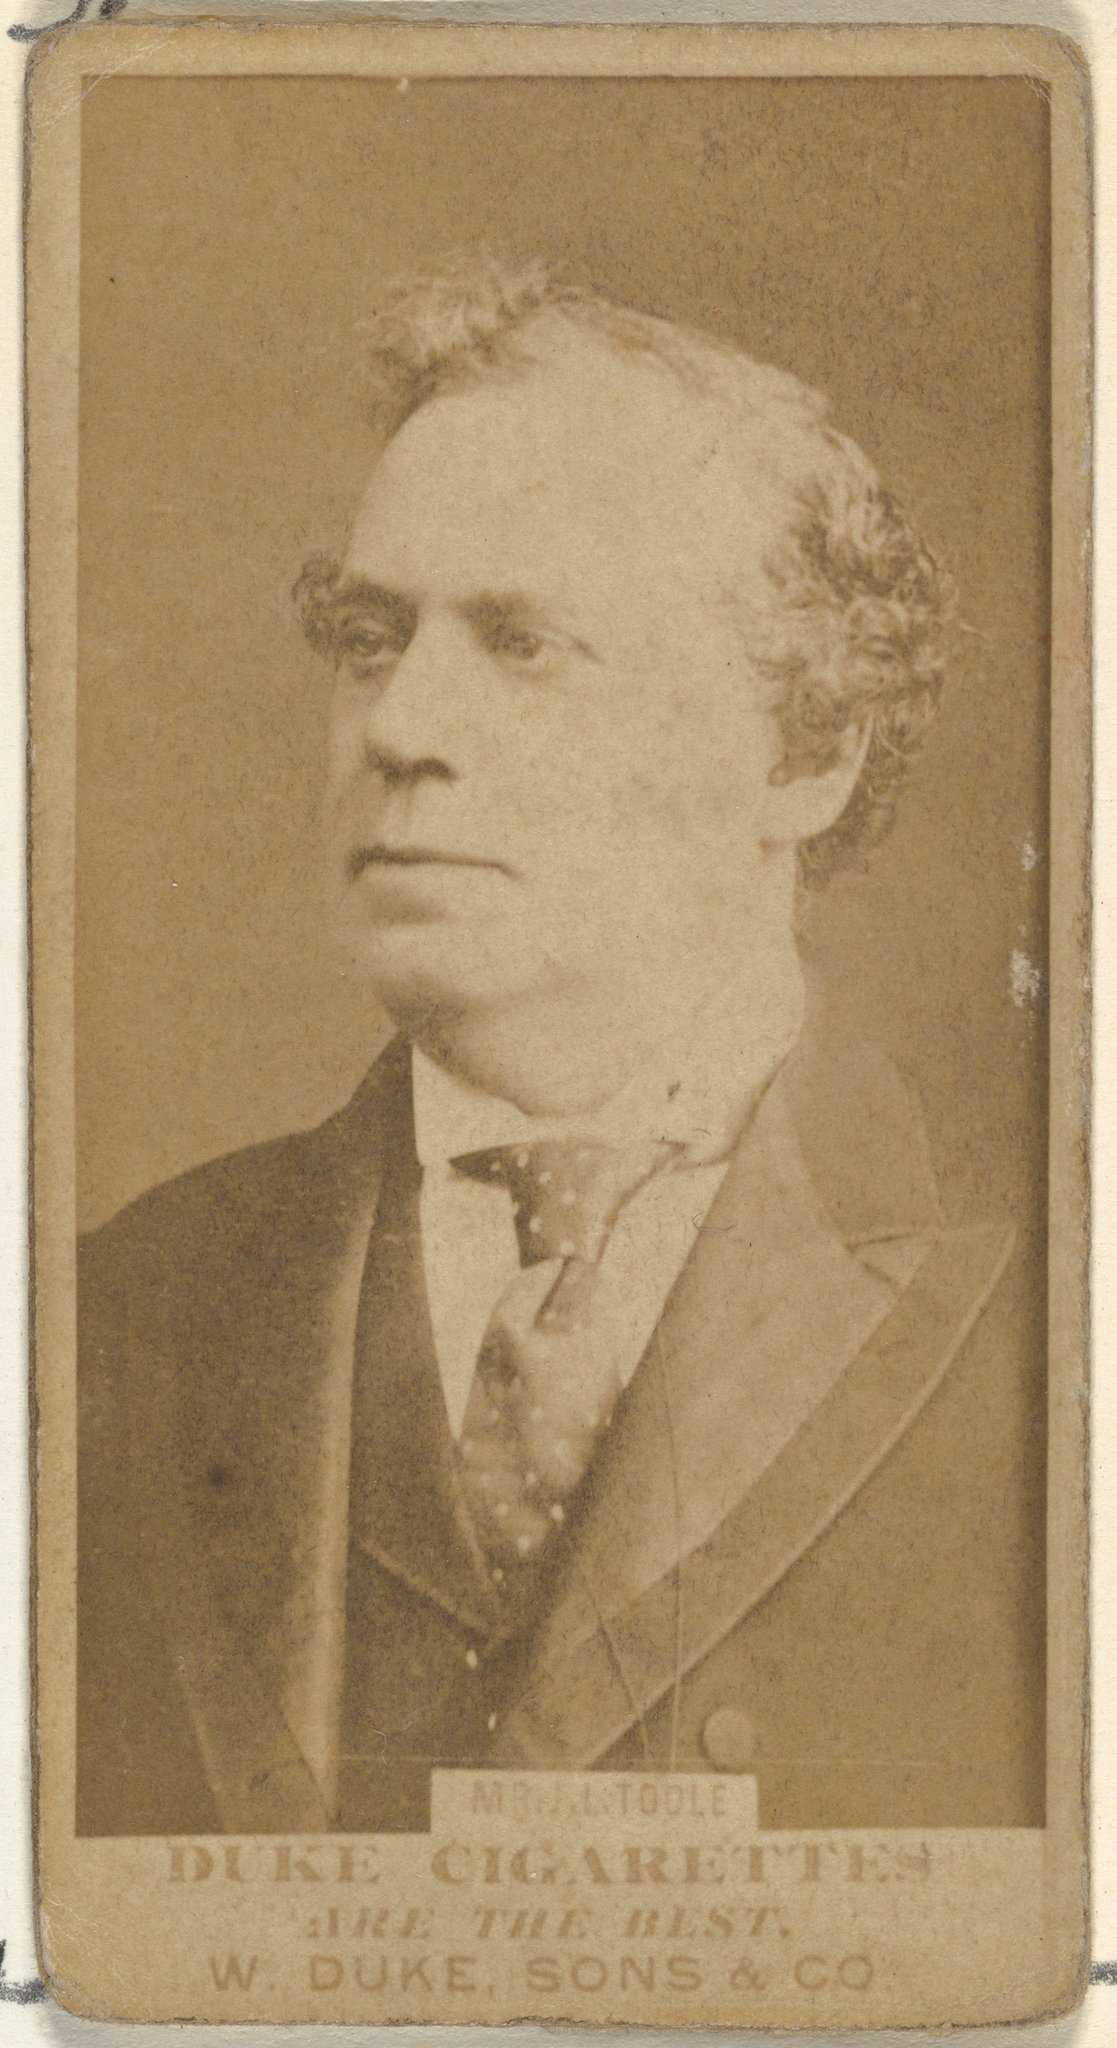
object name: photograph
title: Mr. Toole, from the Actors and Actresses series (N145-7) issued by Duke Sons & Co. to promote Duke Cigarettes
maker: w. duke, sons & co.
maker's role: publisher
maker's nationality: american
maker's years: 1870-1920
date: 1880-1889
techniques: albumen silver print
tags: men,portraits,actors